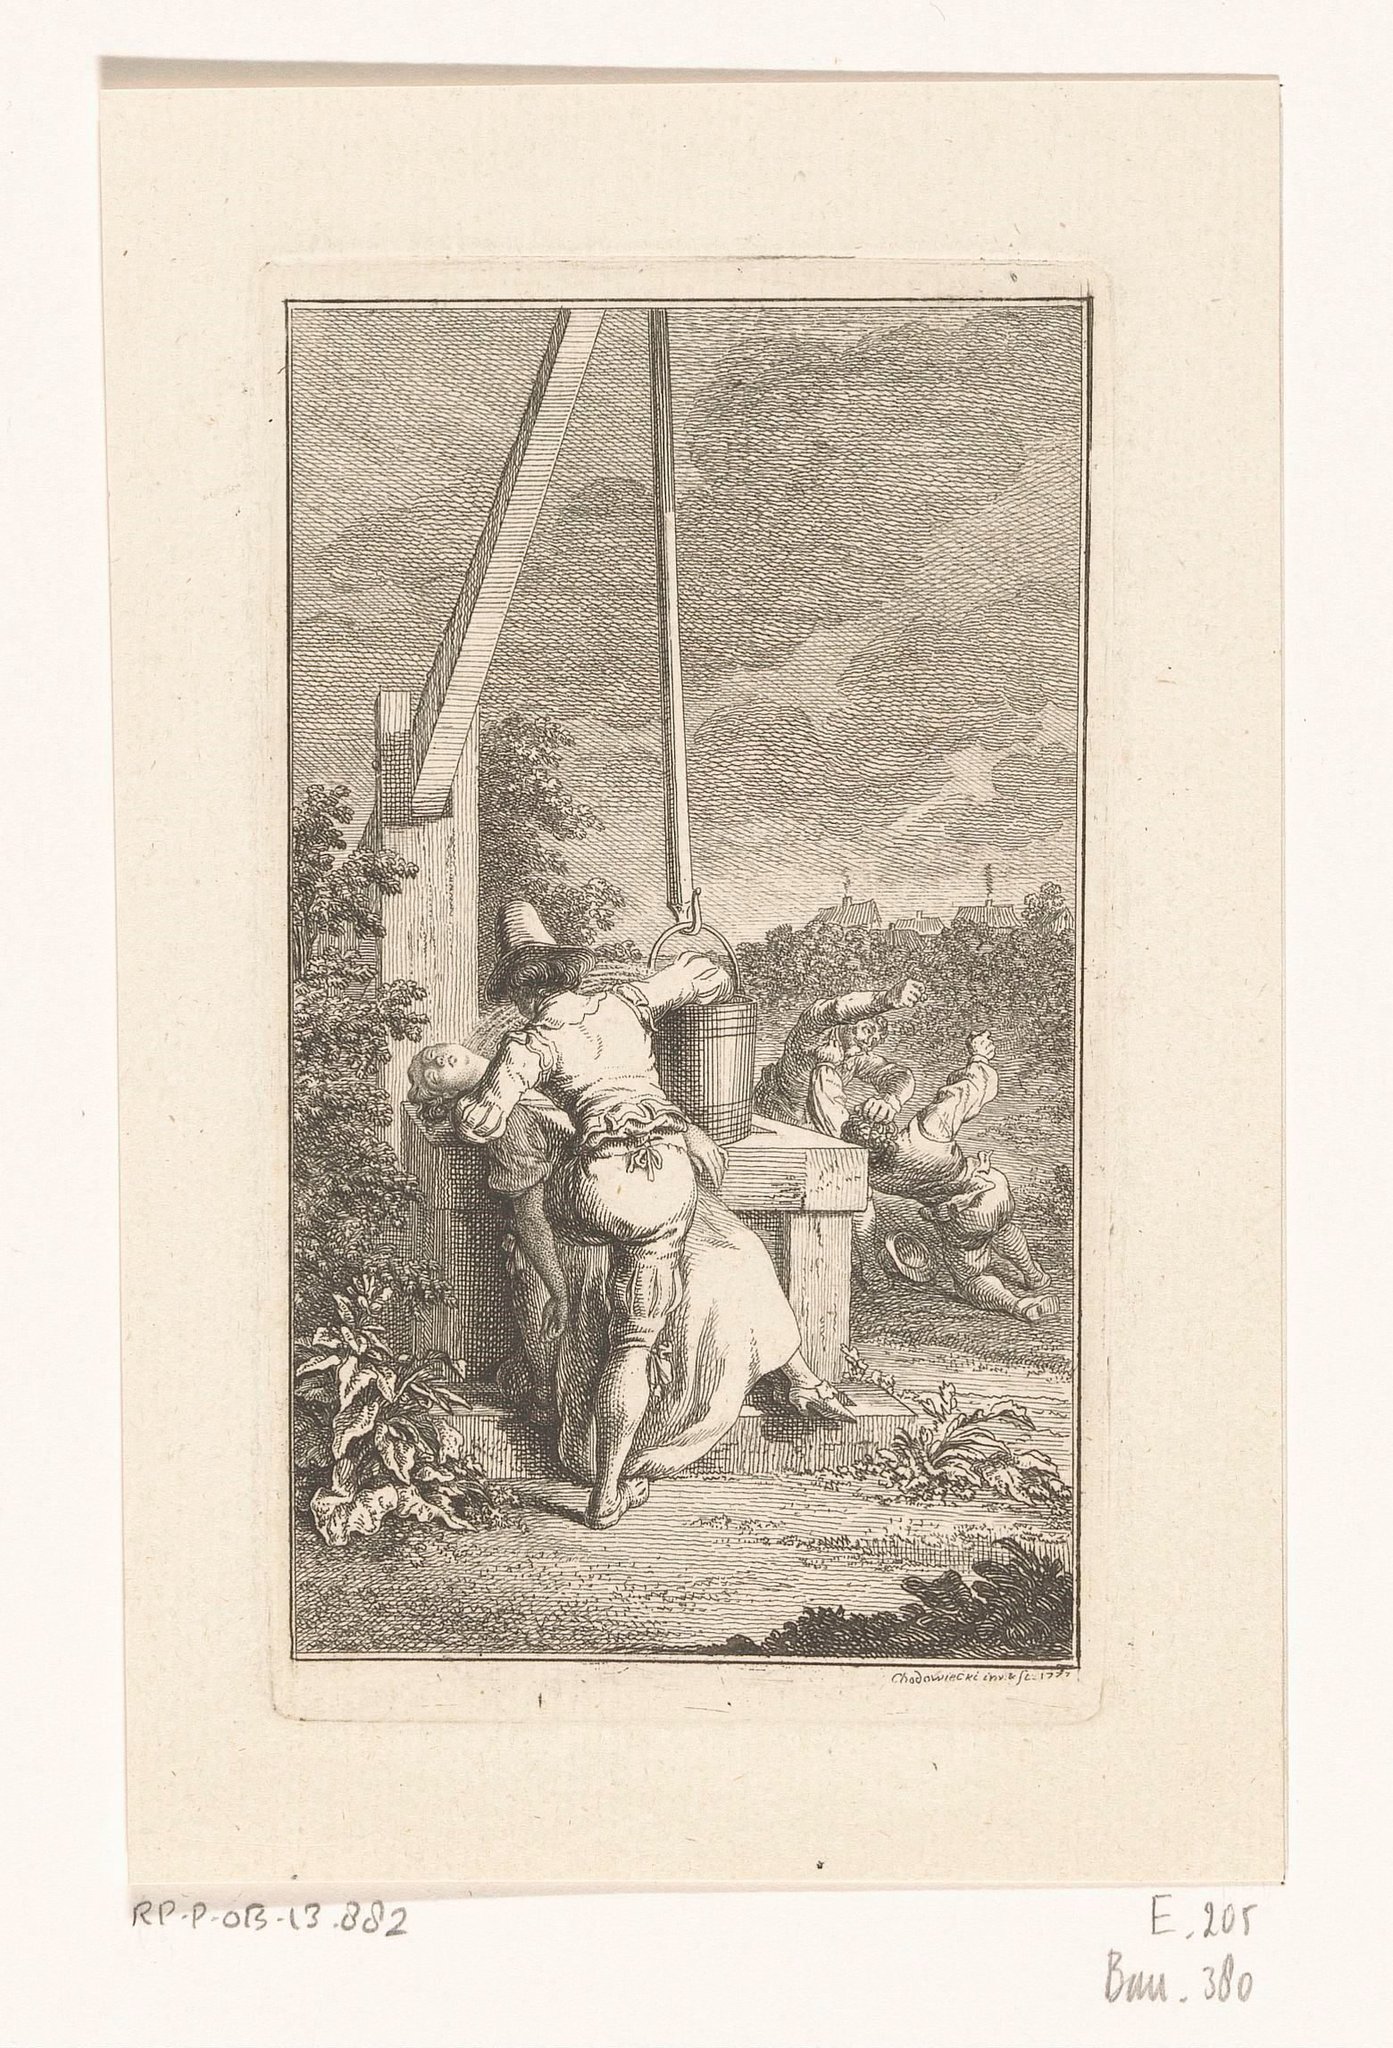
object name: print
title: Vitriolus en Peter Menadie redden een jonge vrouw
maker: daniel nikolaus chodowiecki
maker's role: draughtsman, print maker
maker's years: 1726-1801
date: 1777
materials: paper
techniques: etching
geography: berlin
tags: well, fighting, fainting, swooning - bb - out of doors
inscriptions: collector's mark: Lugt 2228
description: Vitriolus en Peter Menadie zien hoe een jonge vrouw achtervolgd wordt door een kwaadwillende man. Peter Menadie werkt de man tegen de grond terwijl Vitriolus de jonge vrouw probeert bij te brengen met behulp van water uit een put.